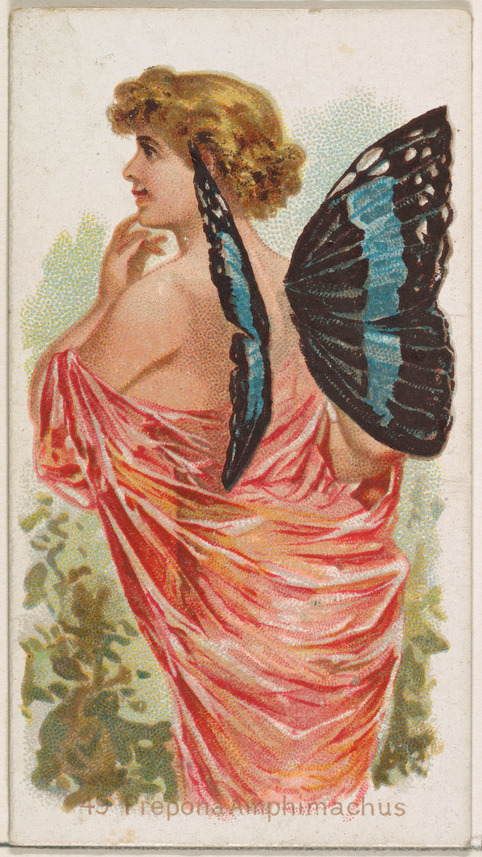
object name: print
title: Card 49, Prepona Amphimachus, from the Butterflies series (N183) issued by Wm. S. Kimball & Co.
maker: william s. kimball & company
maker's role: publisher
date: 1888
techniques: color lithograph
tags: profiles,women,butterflies